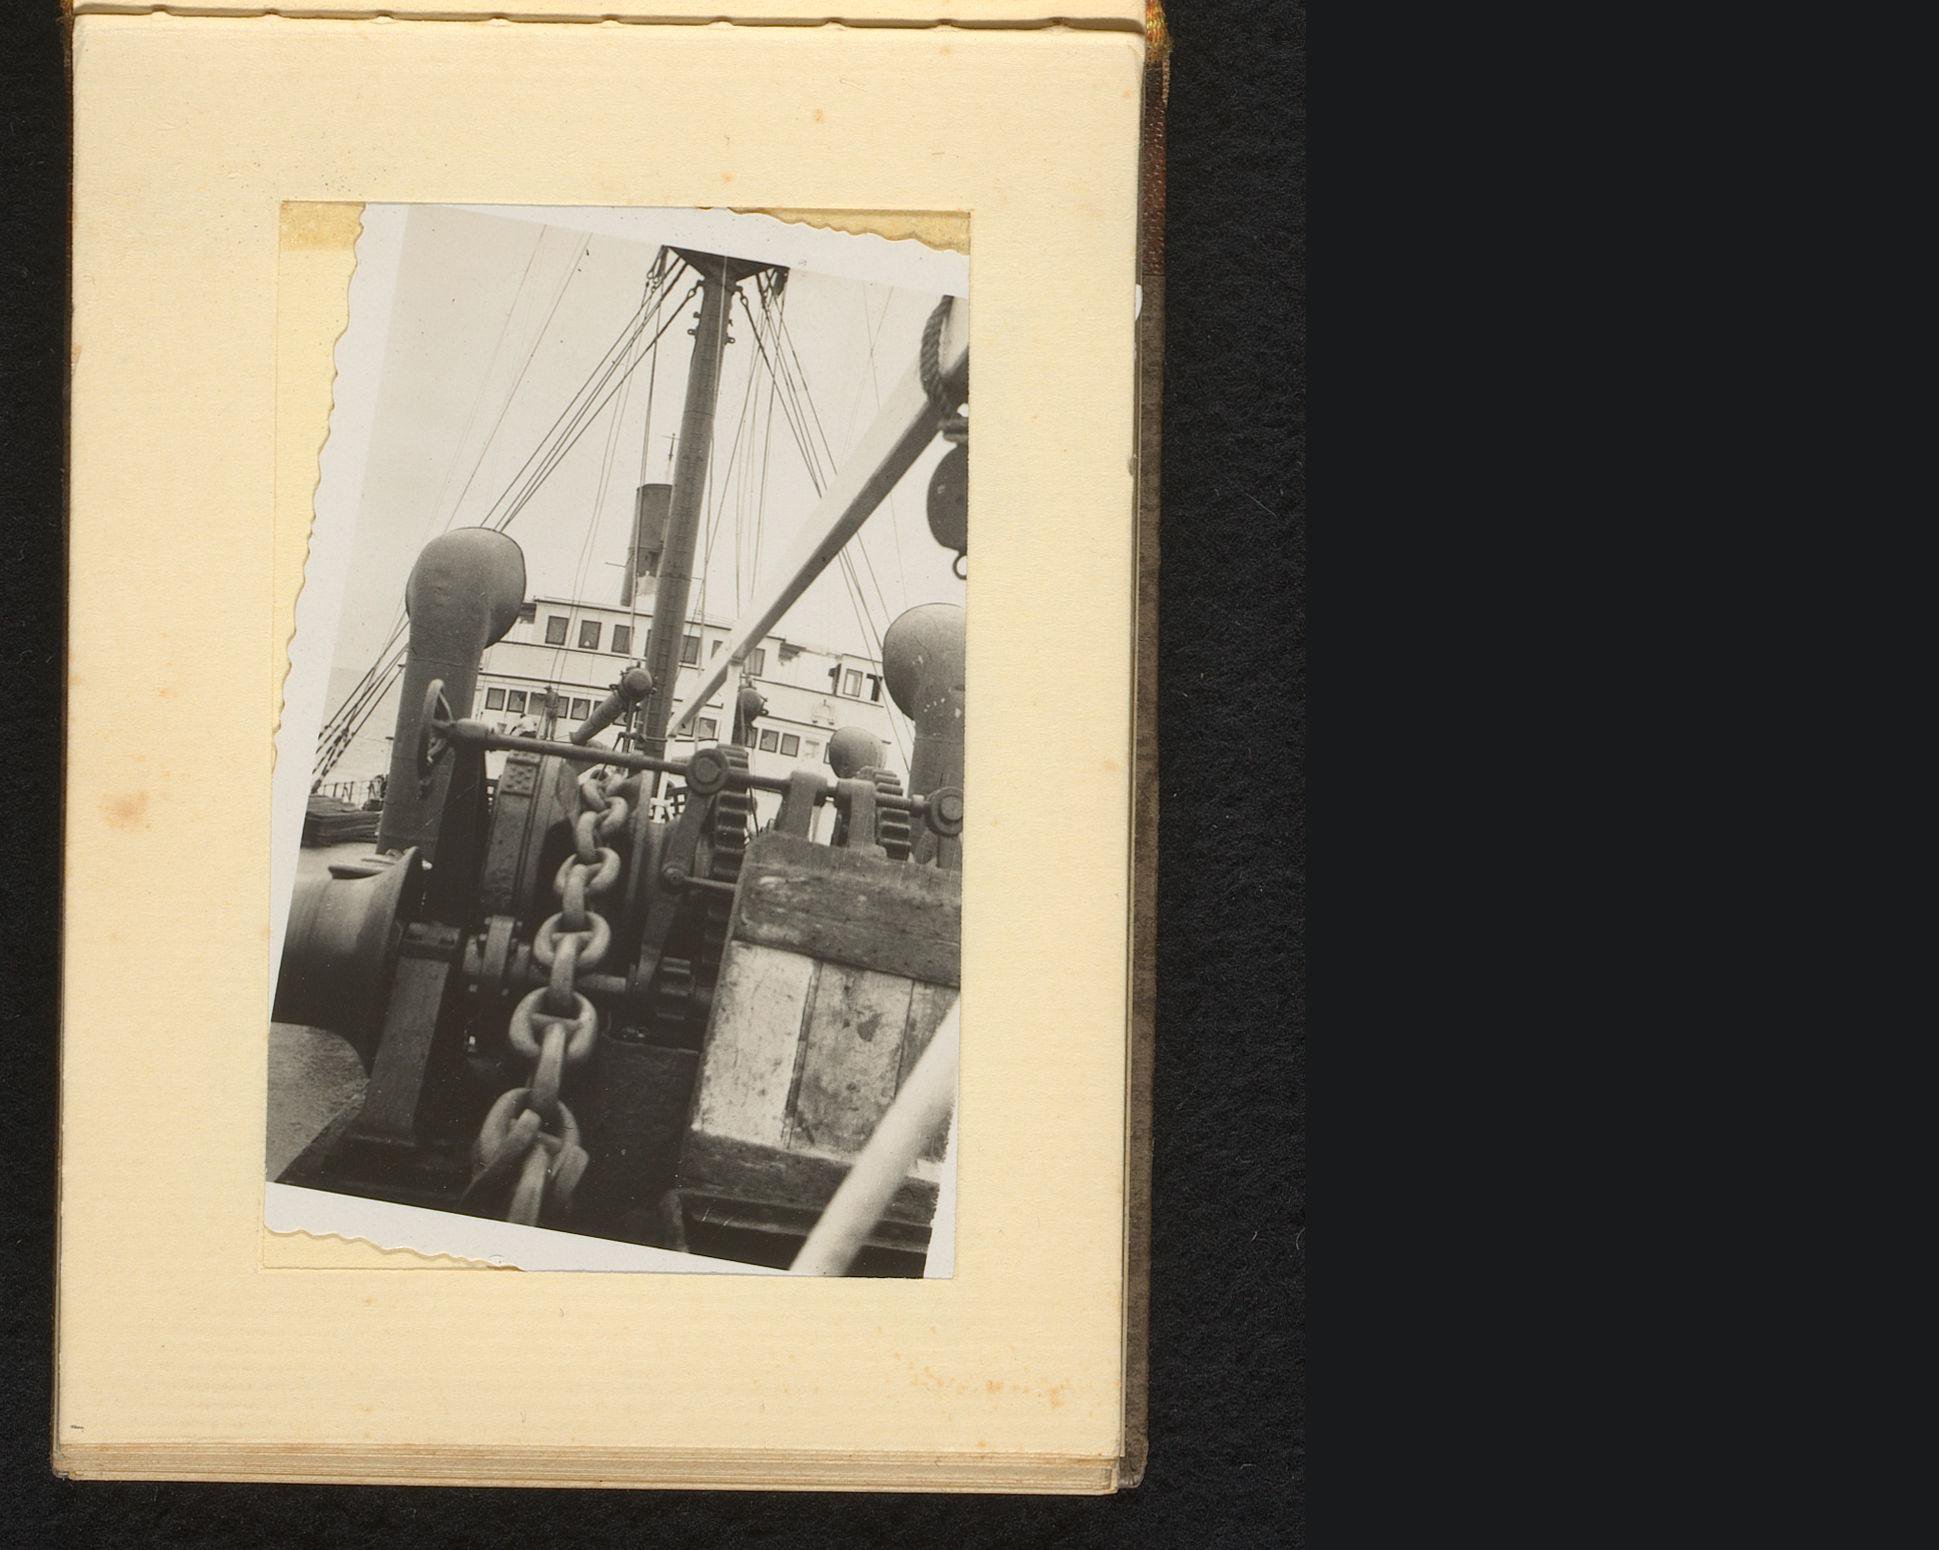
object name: album leaf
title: Gezicht binnen een schip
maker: norbert van den berg (1901-1972)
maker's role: amateurfotograaf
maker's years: 1901-1972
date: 1935-1950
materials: paper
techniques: gelatin silver print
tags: ships (in general), parts of ship's interior